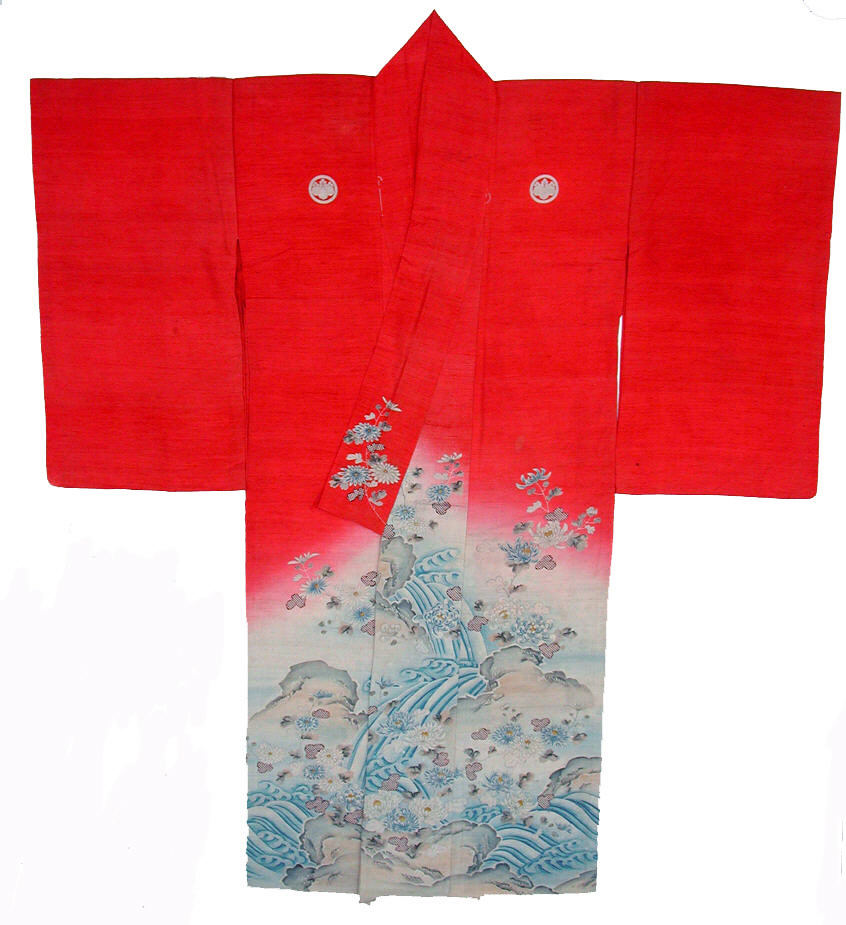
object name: kosode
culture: japanese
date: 1615-1868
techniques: dyeing, painting